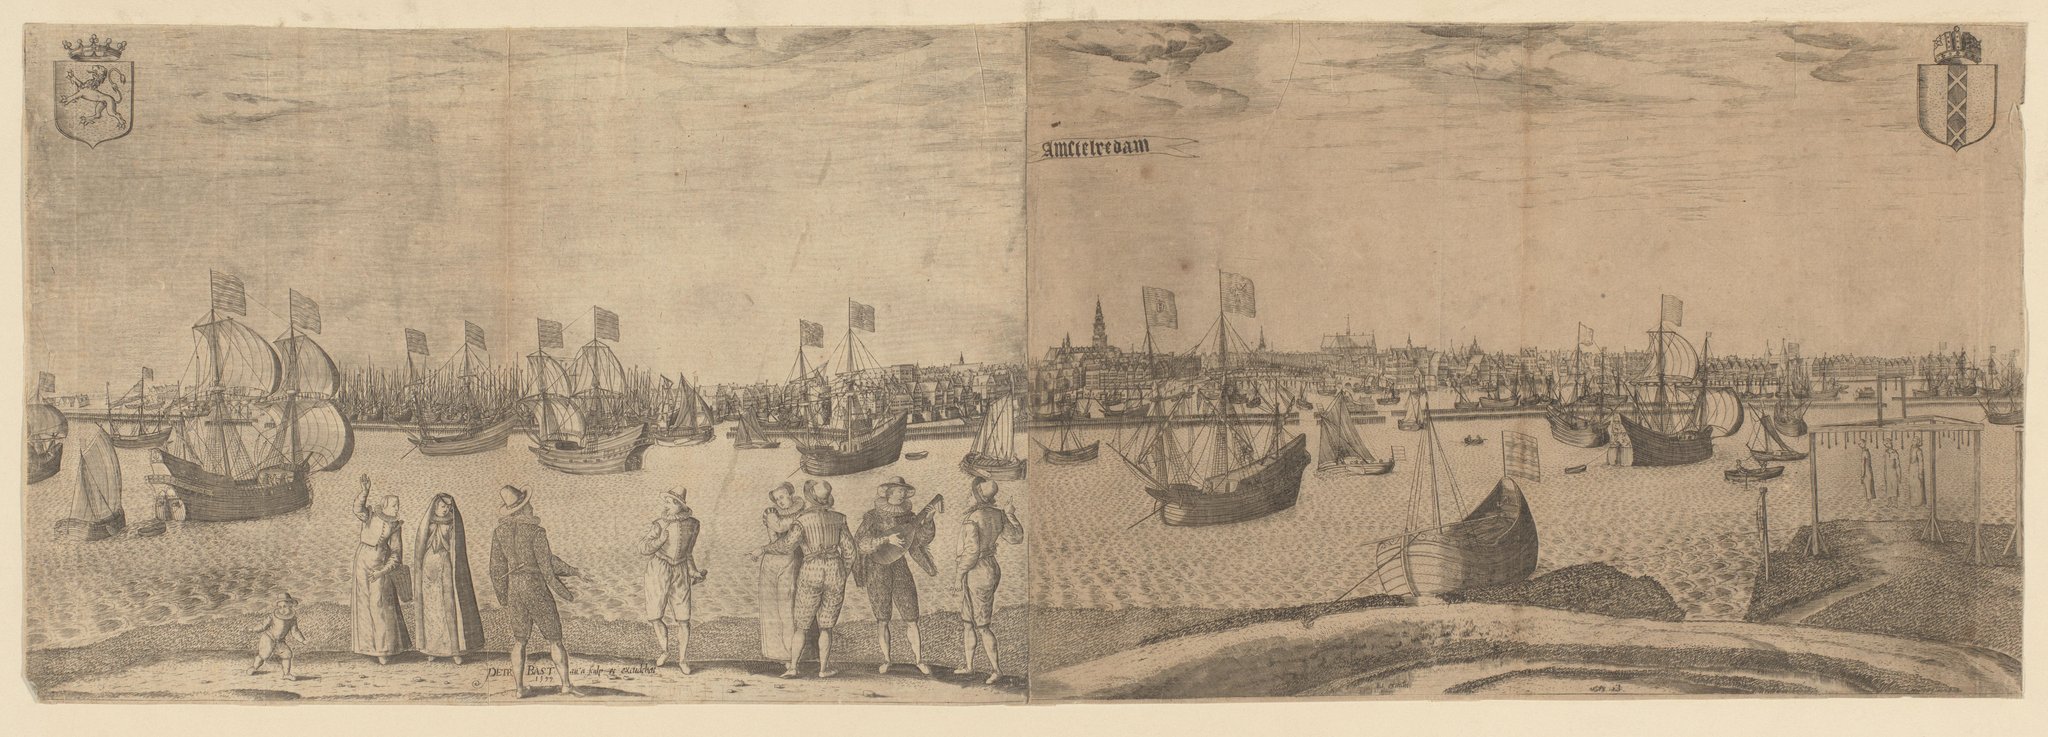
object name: print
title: Amstelredam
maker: pieter bast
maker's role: print maker, publisher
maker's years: 1570-1605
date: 1599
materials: paper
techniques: engraving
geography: amsterdam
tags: harbour, coat of arms (as symbol of the state, etc.) (+ city; municipal), violent death by hanging, ships (in general), coat of arms (as symbol of the state, etc.) (+ province; provincial), prospect of city, town panorama, silhouette of city, amsterdam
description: Gezicht op Amsterdam, gezien vanuit het noorden. Links op de voorgrond een kind, drie vrouwen en vijf mannen, waarvan een een luit bespeelt. Rechts vier lichamen aan de galgen op de Volewijck. Op het middenplan schepen in het IJ. Daarachter de stad met in het midden de Oude Kerk. Linksboven het wapen van Holland, in het midden een banderol met de titel en rechtsboven het wapen van de stad Amsterdam. Object bestaat uit twee aan elkaar geplakte bladen.